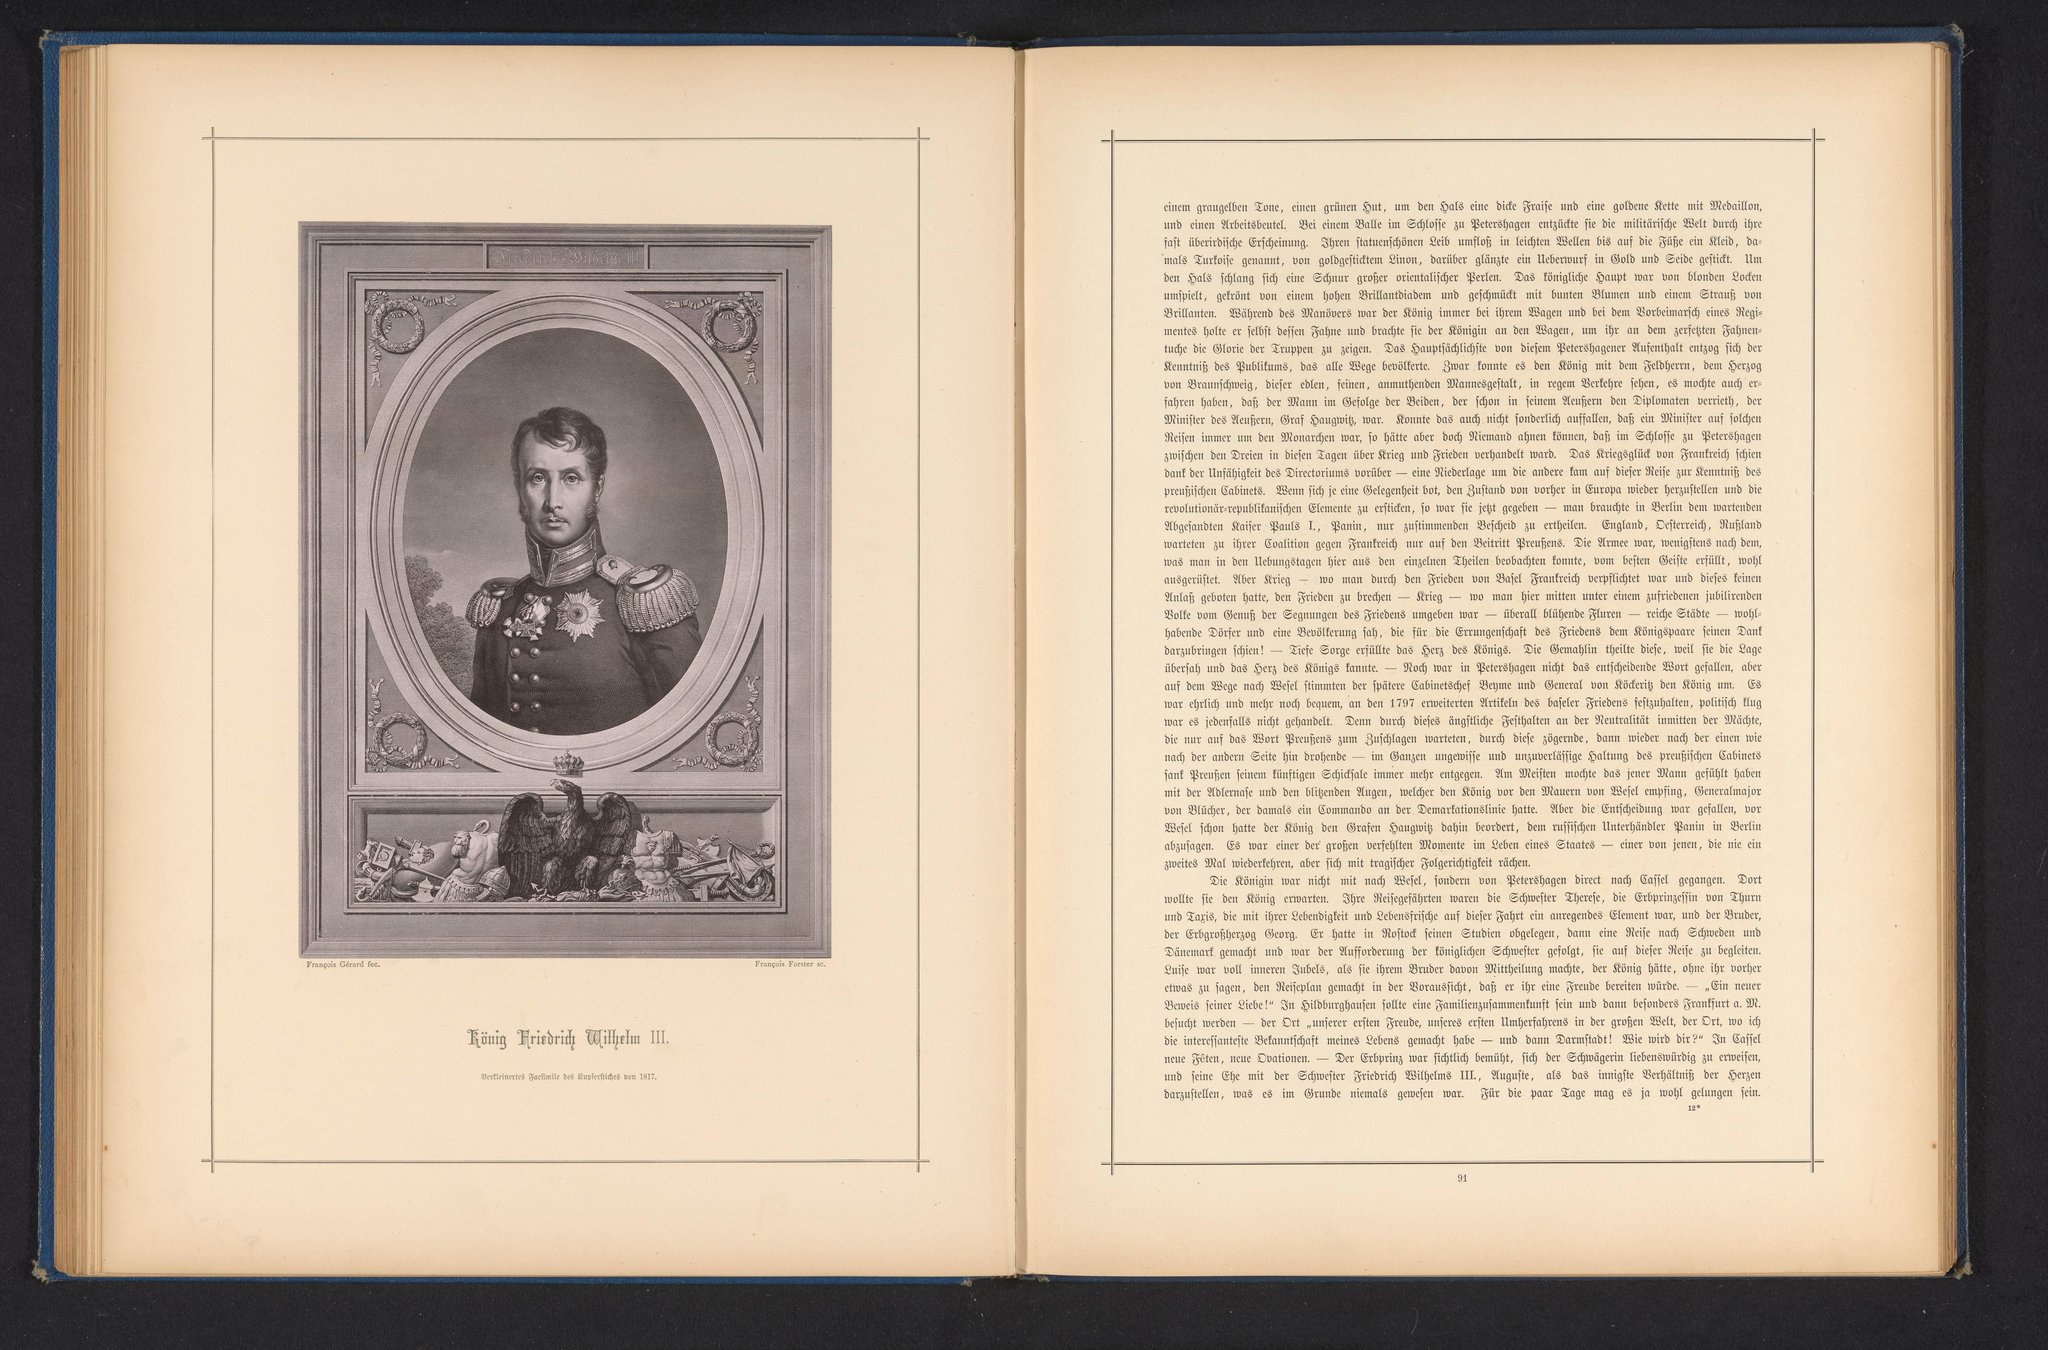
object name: photomechanical print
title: Fotoreproductie van een portret van Frederik Willem III van Pruisen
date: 1873-1883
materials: paper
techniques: photograph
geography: berlin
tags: berlin, frederik willem iii koning van pruisen, king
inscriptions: inscription: ‘[...]leinertes facsimile des [...] von 1817.’